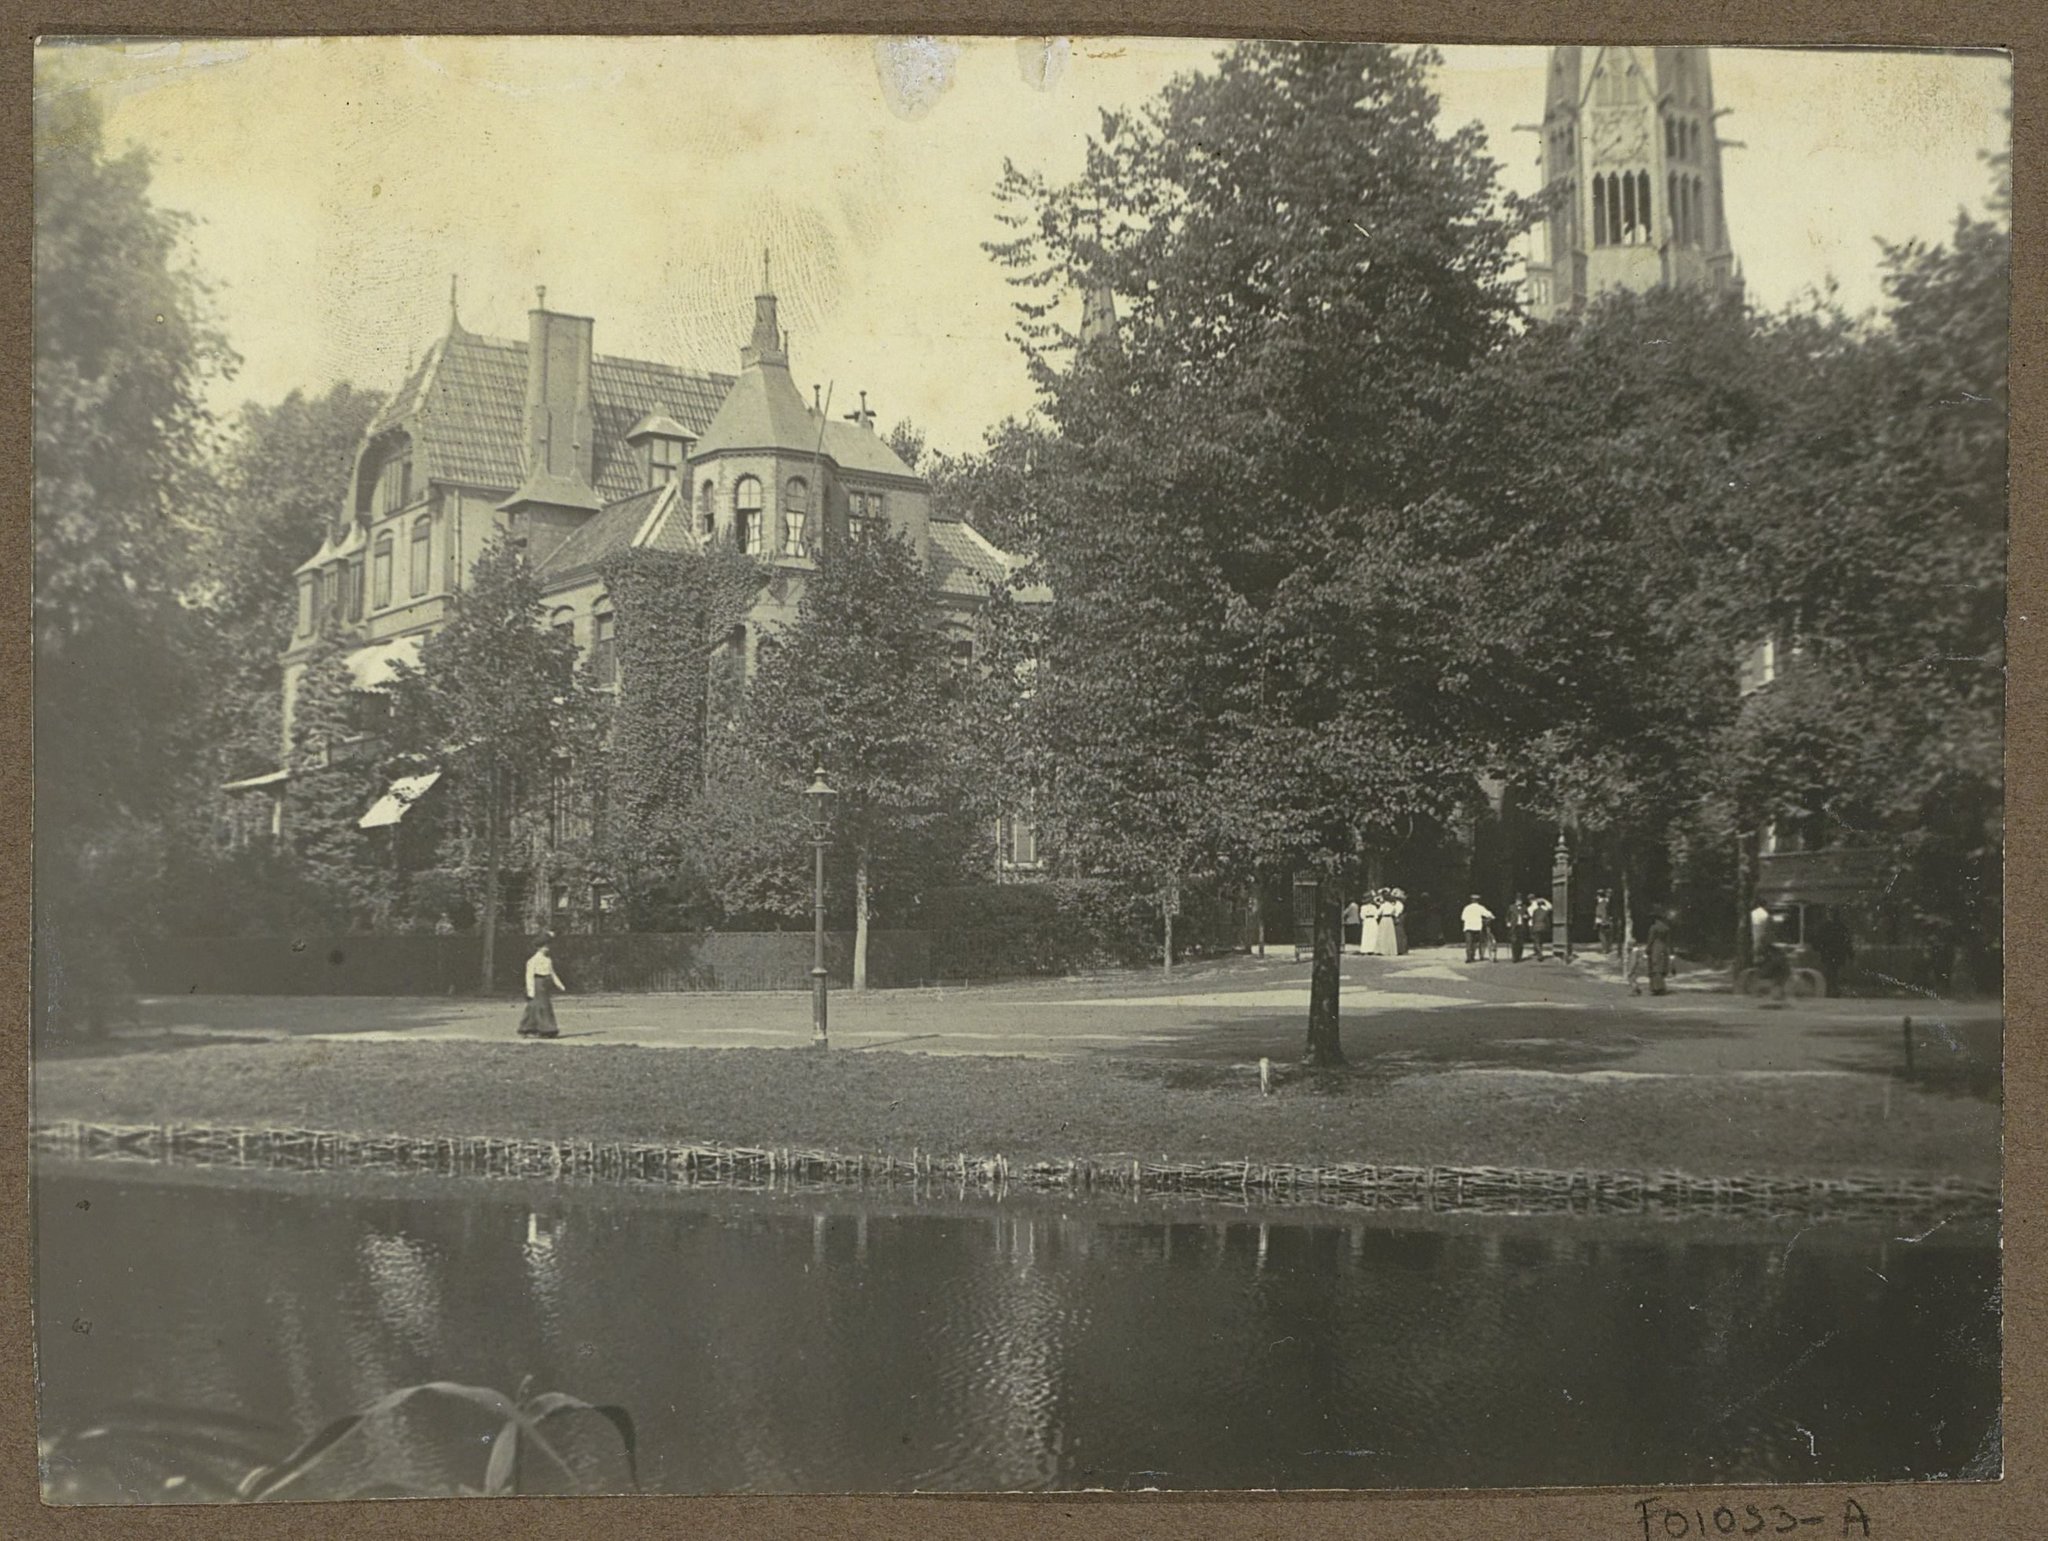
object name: photograph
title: Woonhuis aan het Amsterdamse Vondelpark met rechts de toren van de Vondelkerk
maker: Anonymous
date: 1900-1915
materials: paper, photographic support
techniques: gelatin silver print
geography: amsterdam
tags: public gardens, park (+ city(-scape) with figures, staffage)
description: Gezicht vanuit het Vondelparp op het woonhuis Vondelstraat 73, met rechts de toren van de Vondelkerk. Onderdeel van Album met foto's van Amsterdam en omgeving.